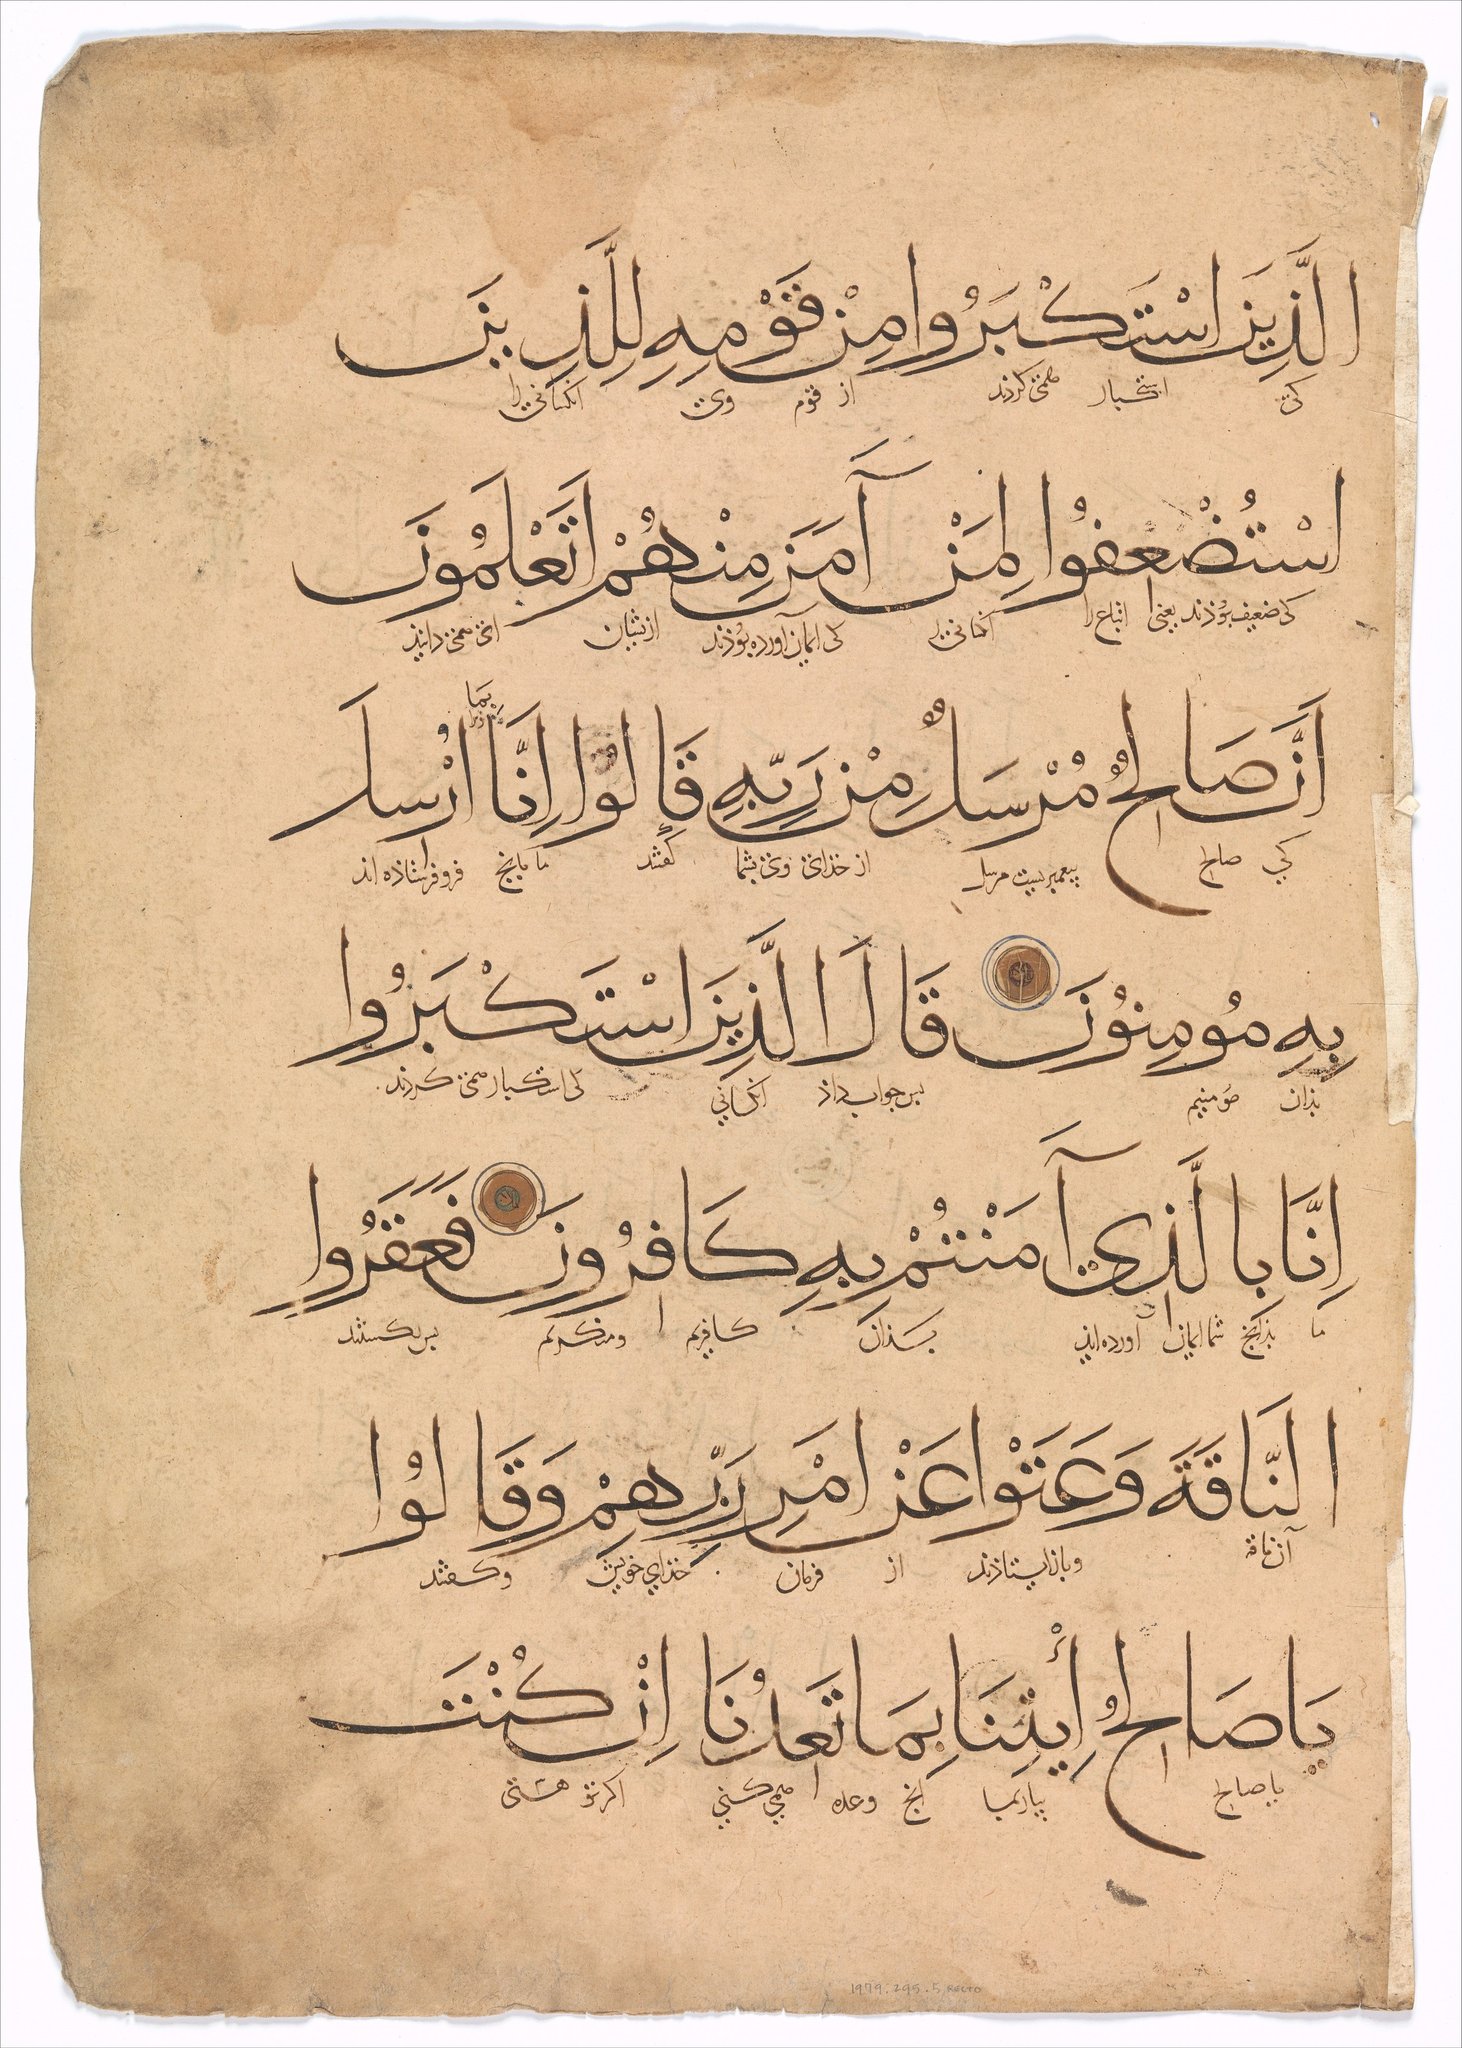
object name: folio from a non illustrated manuscript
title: Folio from a Qur'an Manuscript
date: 1301-1400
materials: gold, ink, paper, watercolor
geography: india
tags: qur'an,calligraphy